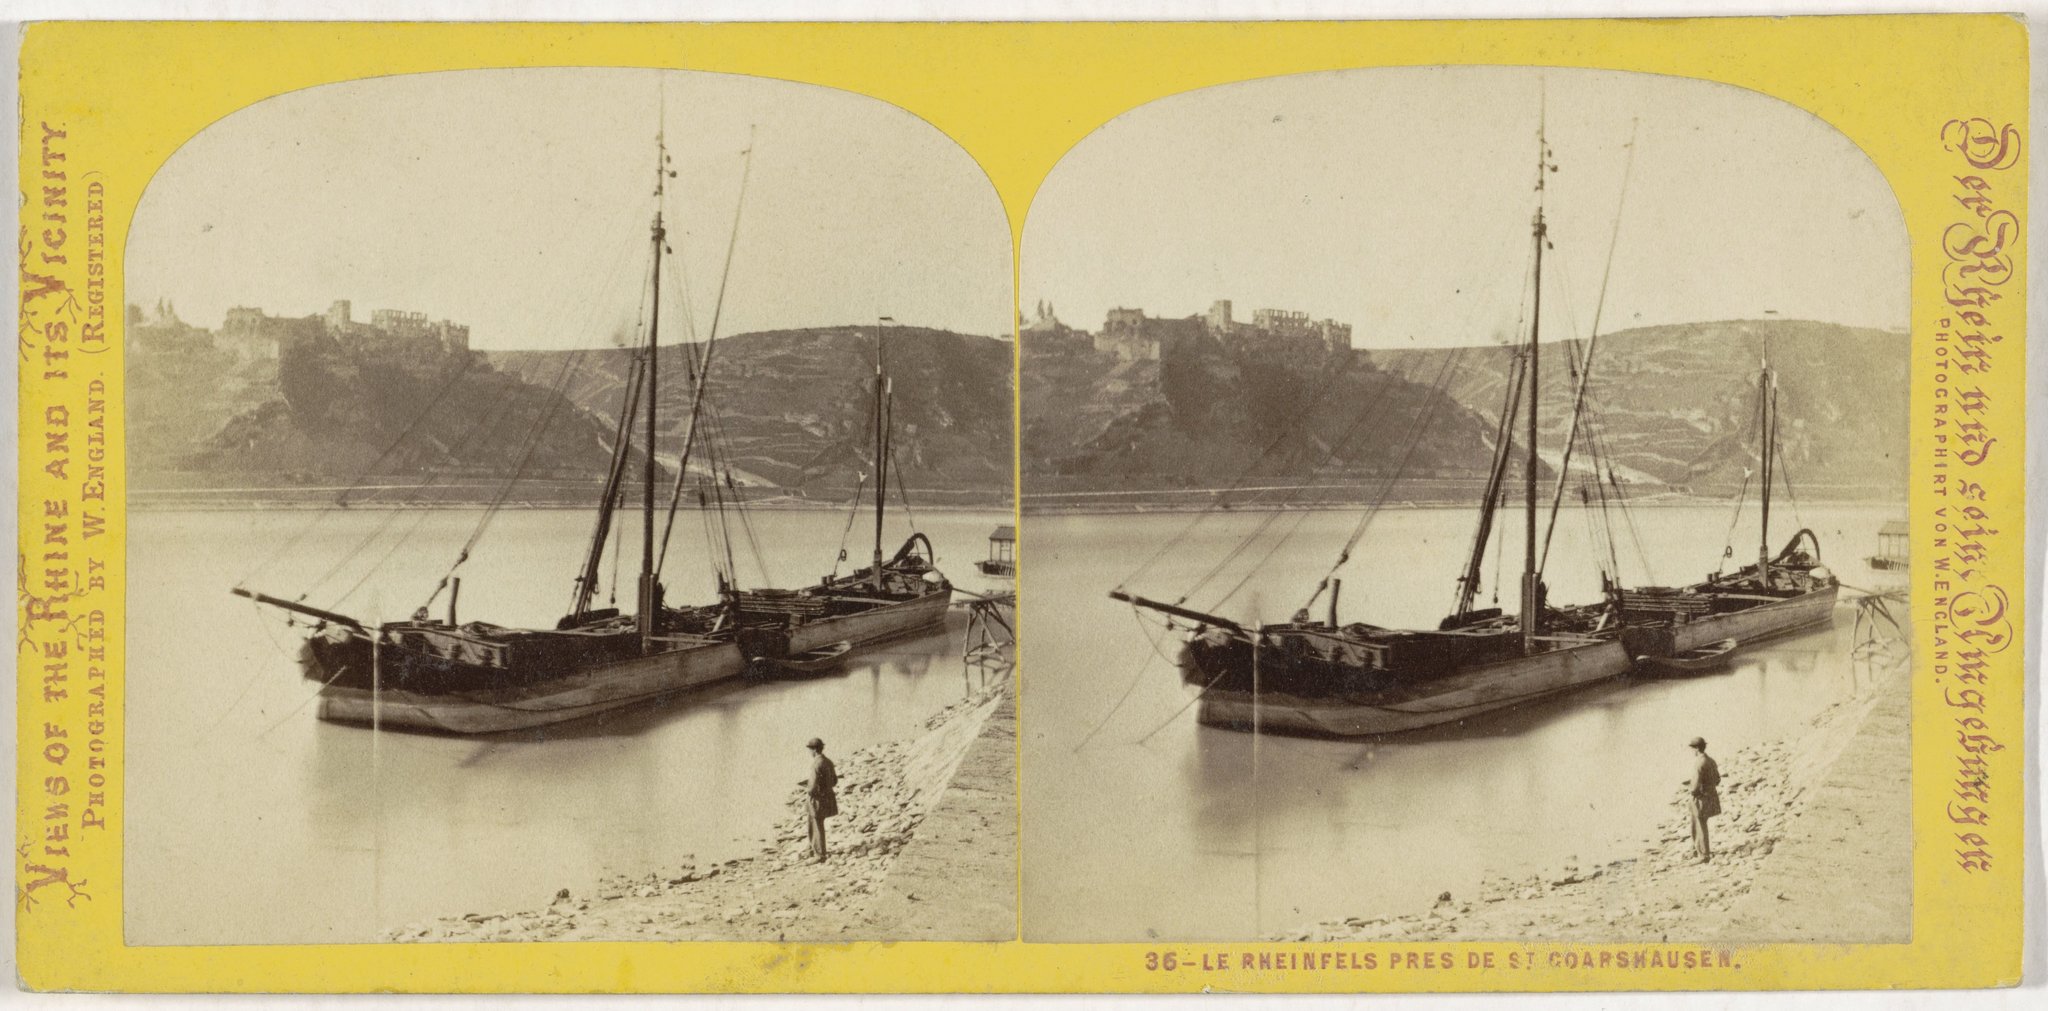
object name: stereograph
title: Gezicht op burcht Rheinfels nabij Sankt Goarshausen met op de voorgrond een boot op de Rijn, Duitsland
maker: william england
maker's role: fotograaf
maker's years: 1816-1896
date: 1867-1868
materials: cardboard, paper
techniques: albumen print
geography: sankt goarshausen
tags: river, ships (in general), landscape with tower or castle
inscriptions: inscription: ‘(Registered)’, number: ‘36’, inscription: ‘75’